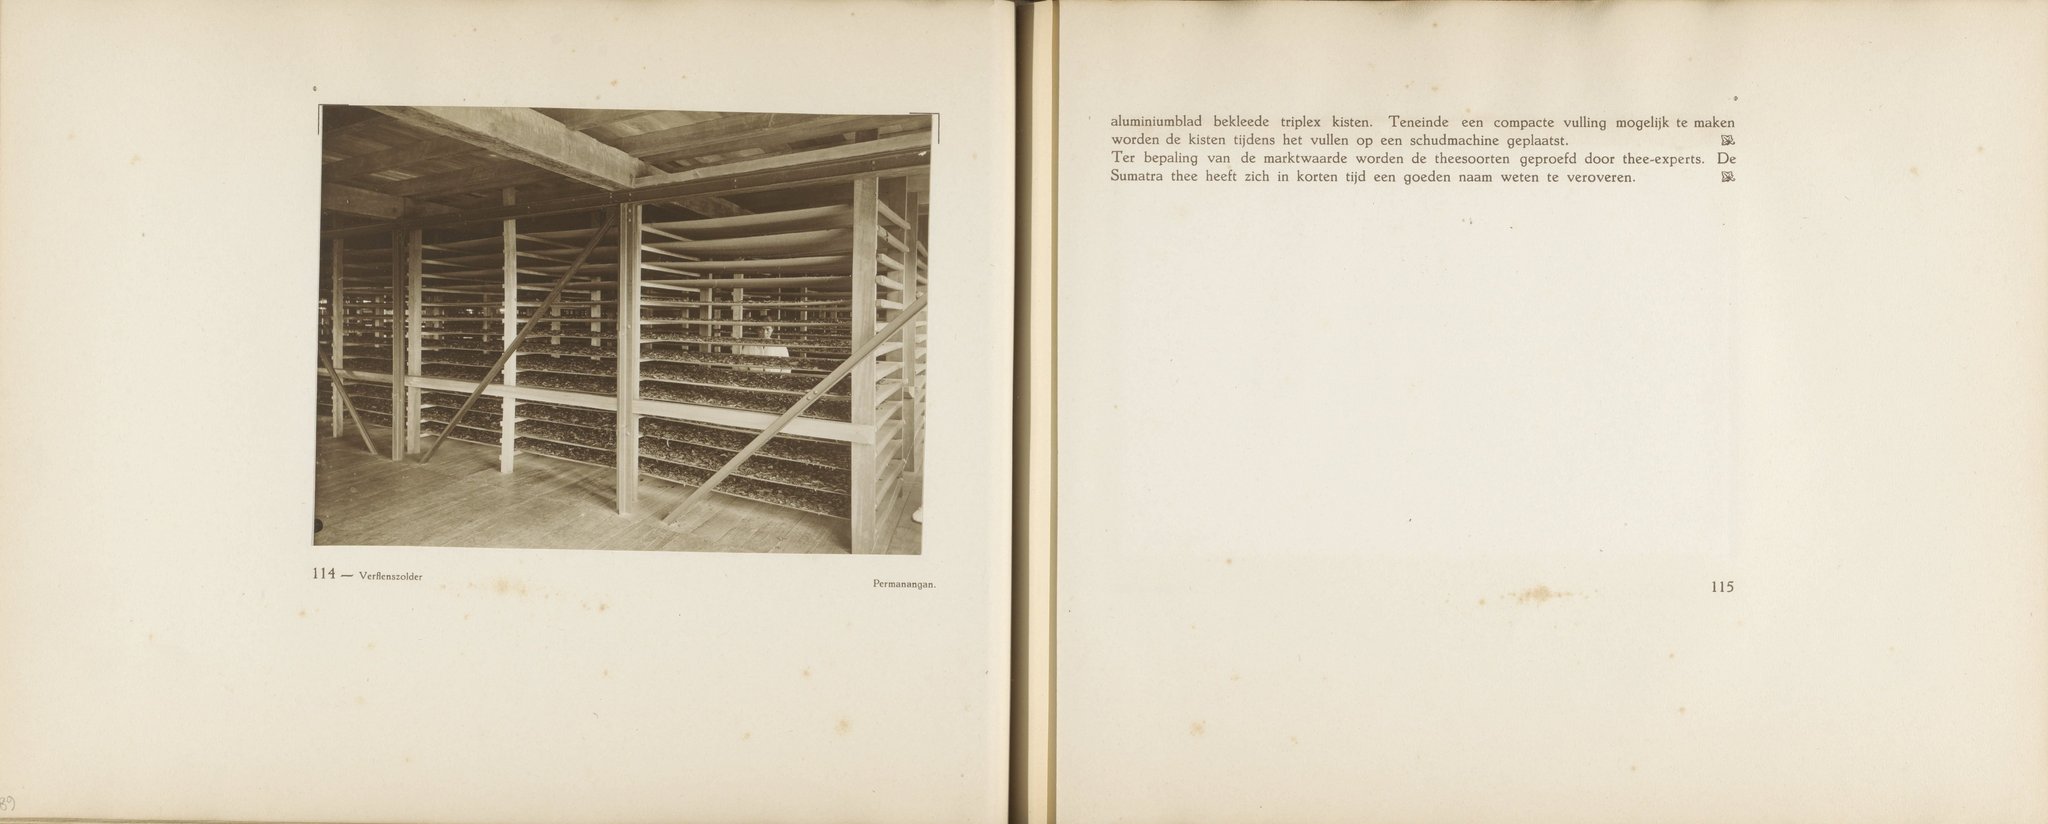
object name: album leaf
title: Pagina 114 en 115 van fotoboek van de Algemeene Vereeniging van Rubberplanters ter Oostkust van Sumatra (A.V.R.O.S.)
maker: j.w. meyster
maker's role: fotograaf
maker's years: 1887-1945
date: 1924-1925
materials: paper, photographic support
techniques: printing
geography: sumatra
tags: factory-building, (non-fruit) products of plants or trees: rubber, tea (leaves), sumatra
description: Twee boekpagina's met links een foto van een verflenszolder van een theefabriek te Permanangan en rechts informatie over fabriekmatige theebereiding. Onderdeel van een fotoboek van de Algemeene Vereeniging van Rubberplanters ter Oostkust van Sumatra (A.V.R.O.S.).